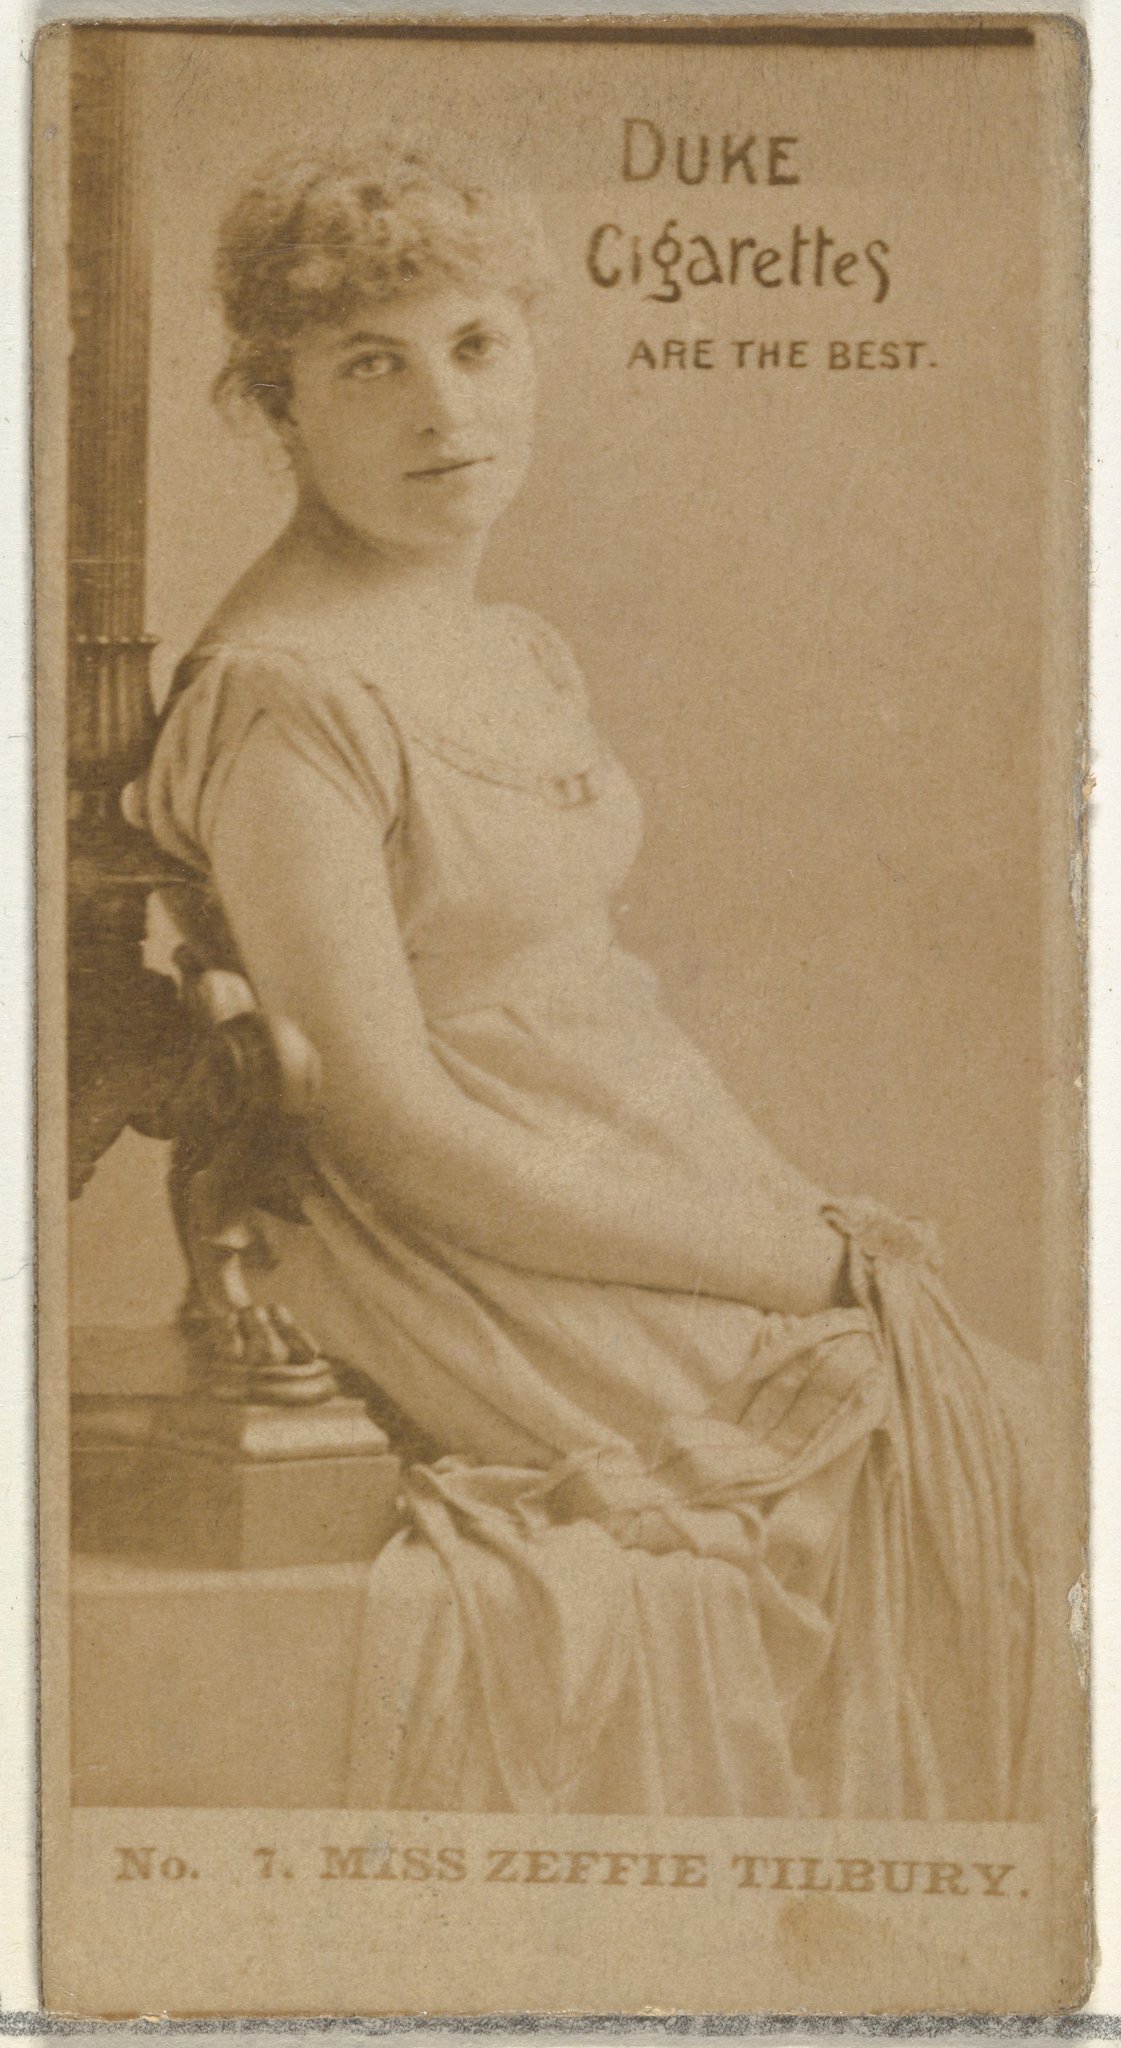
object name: photograph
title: Card Number 7, Miss Zeffie Tilbury, from the Actors and Actresses series (N145-6) issued by Duke Sons & Co. to promote Duke Cigarettes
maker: w. duke, sons & co.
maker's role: publisher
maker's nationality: american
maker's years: 1870-1920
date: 1880-1889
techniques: albumen silver print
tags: portraits,women,actresses